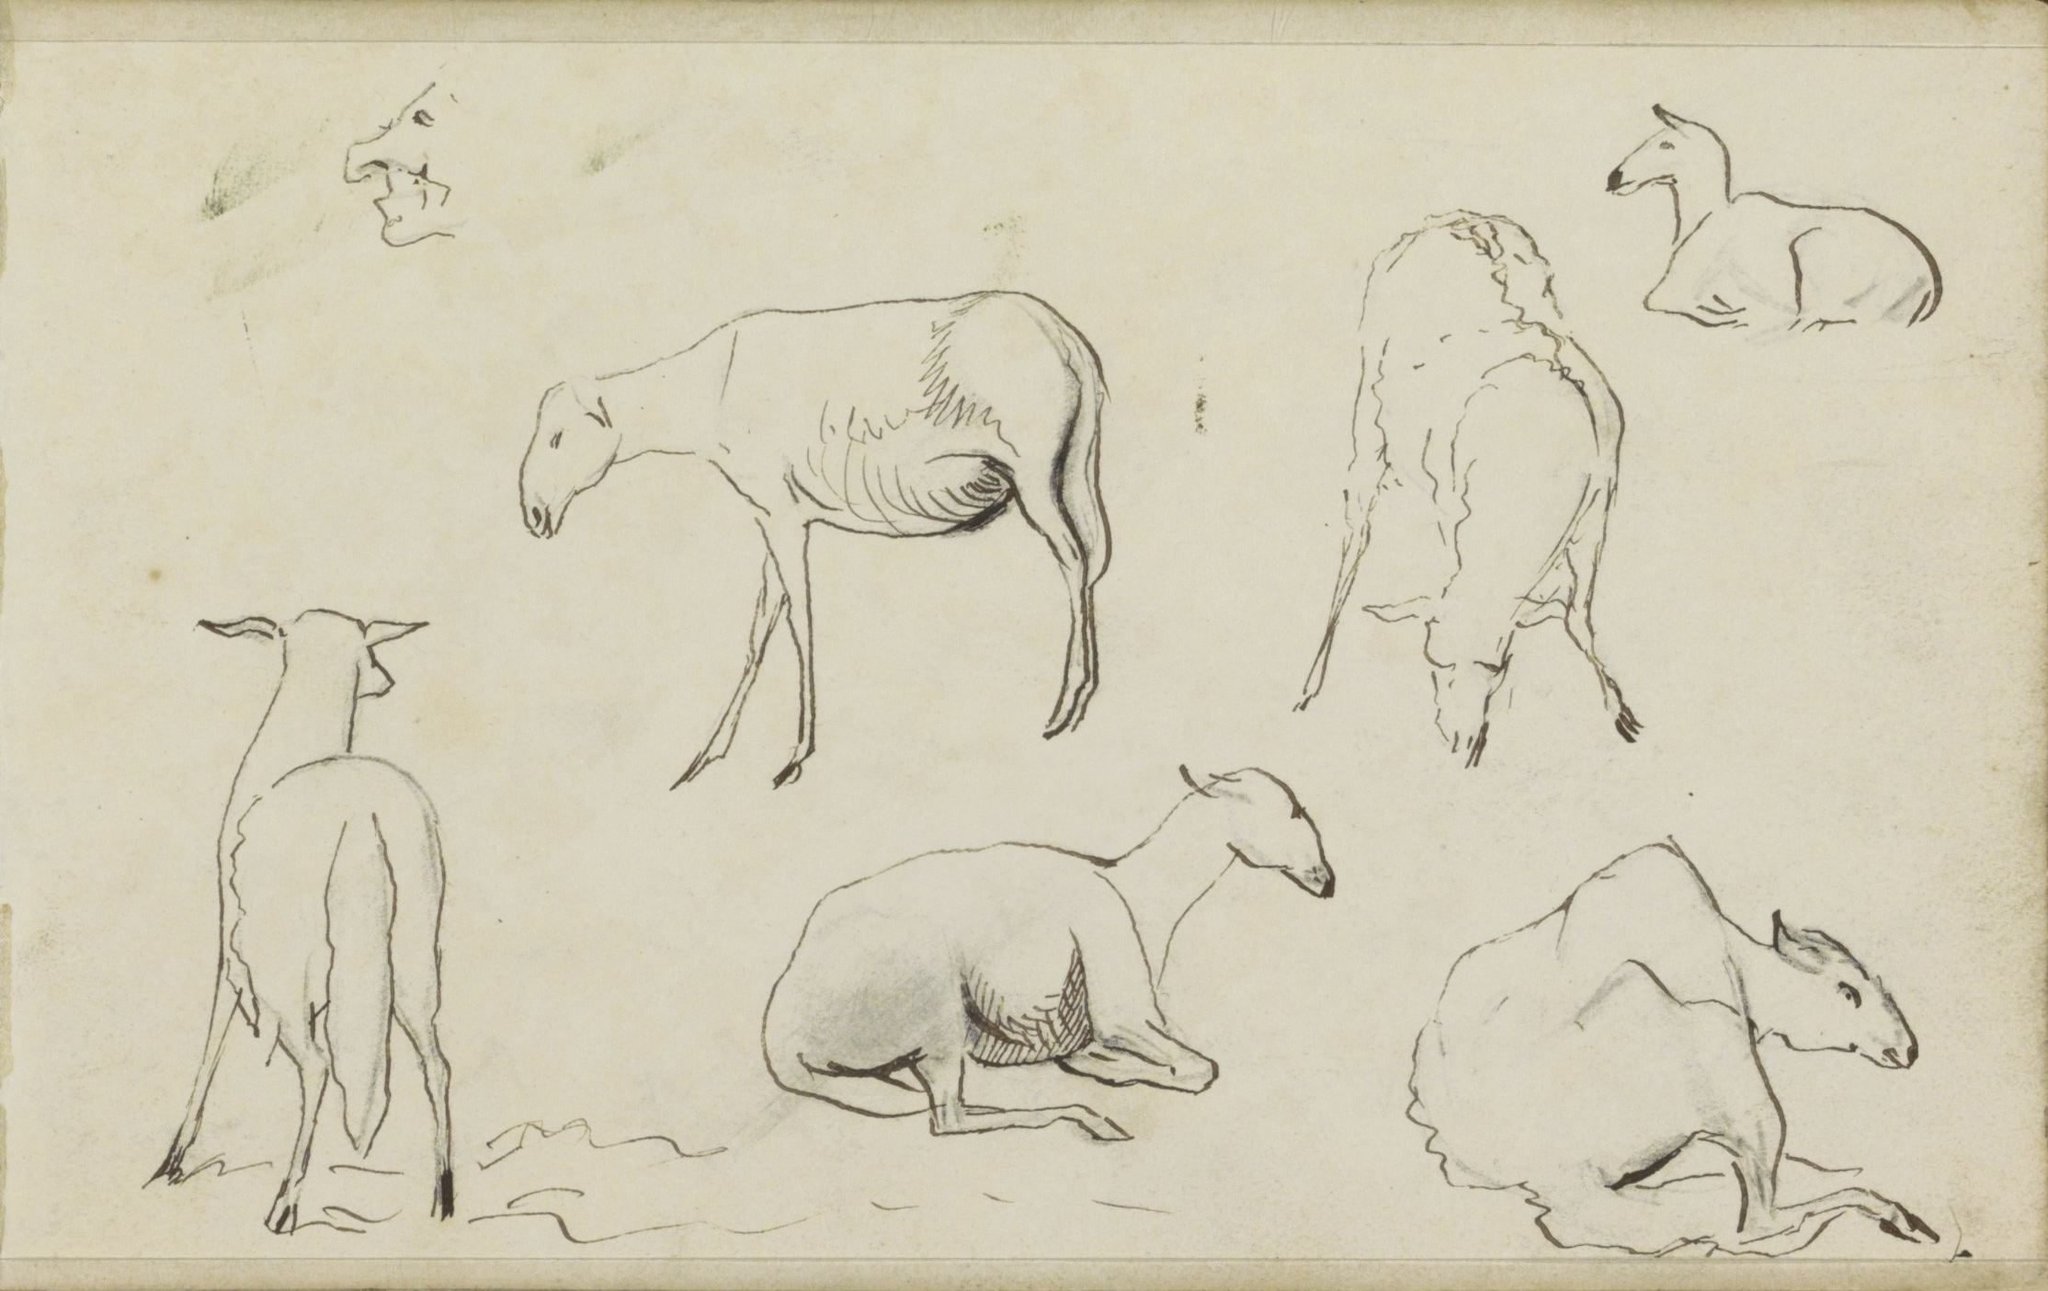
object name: sketchbook leaf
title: Schapen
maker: johannes tavenraat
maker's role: draughtsman, painter, print maker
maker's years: 1809-1881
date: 1839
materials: paper, pencil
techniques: pen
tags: head (human), sheep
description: Tevens een kop met een haakneus. Blad 7 recto uit een schetsboek met 37 bladen.